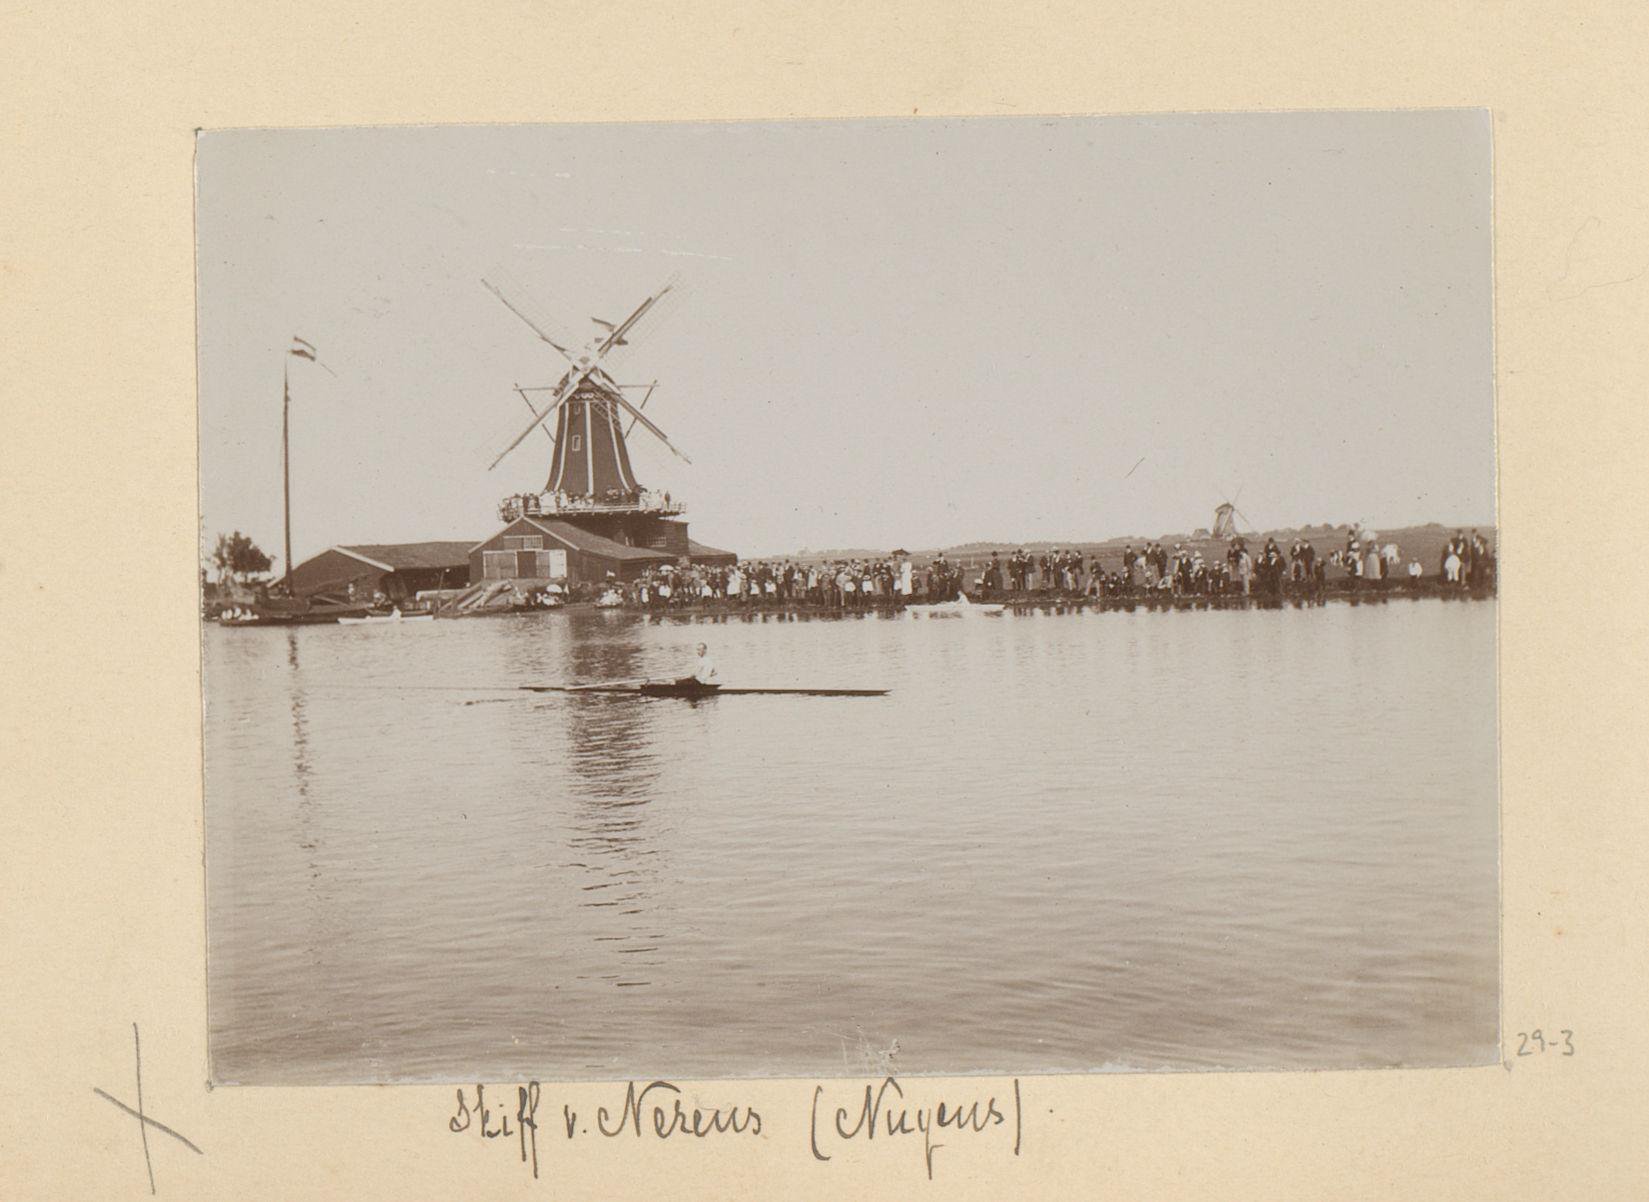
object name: album leaf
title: Skiff van de Amsterdamse roeivereniging Nereus tijdens de Varsity van 1893 in Haarlem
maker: hendrik herman van den berg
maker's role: amateurfotograaf, jurist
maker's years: 1875-1944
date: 1893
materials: paper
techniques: collodion silver print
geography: haarlem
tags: rowing facing backward, pulling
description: Foto 3 op albumblad 29 uit album "Amsterdam 1890-1894".